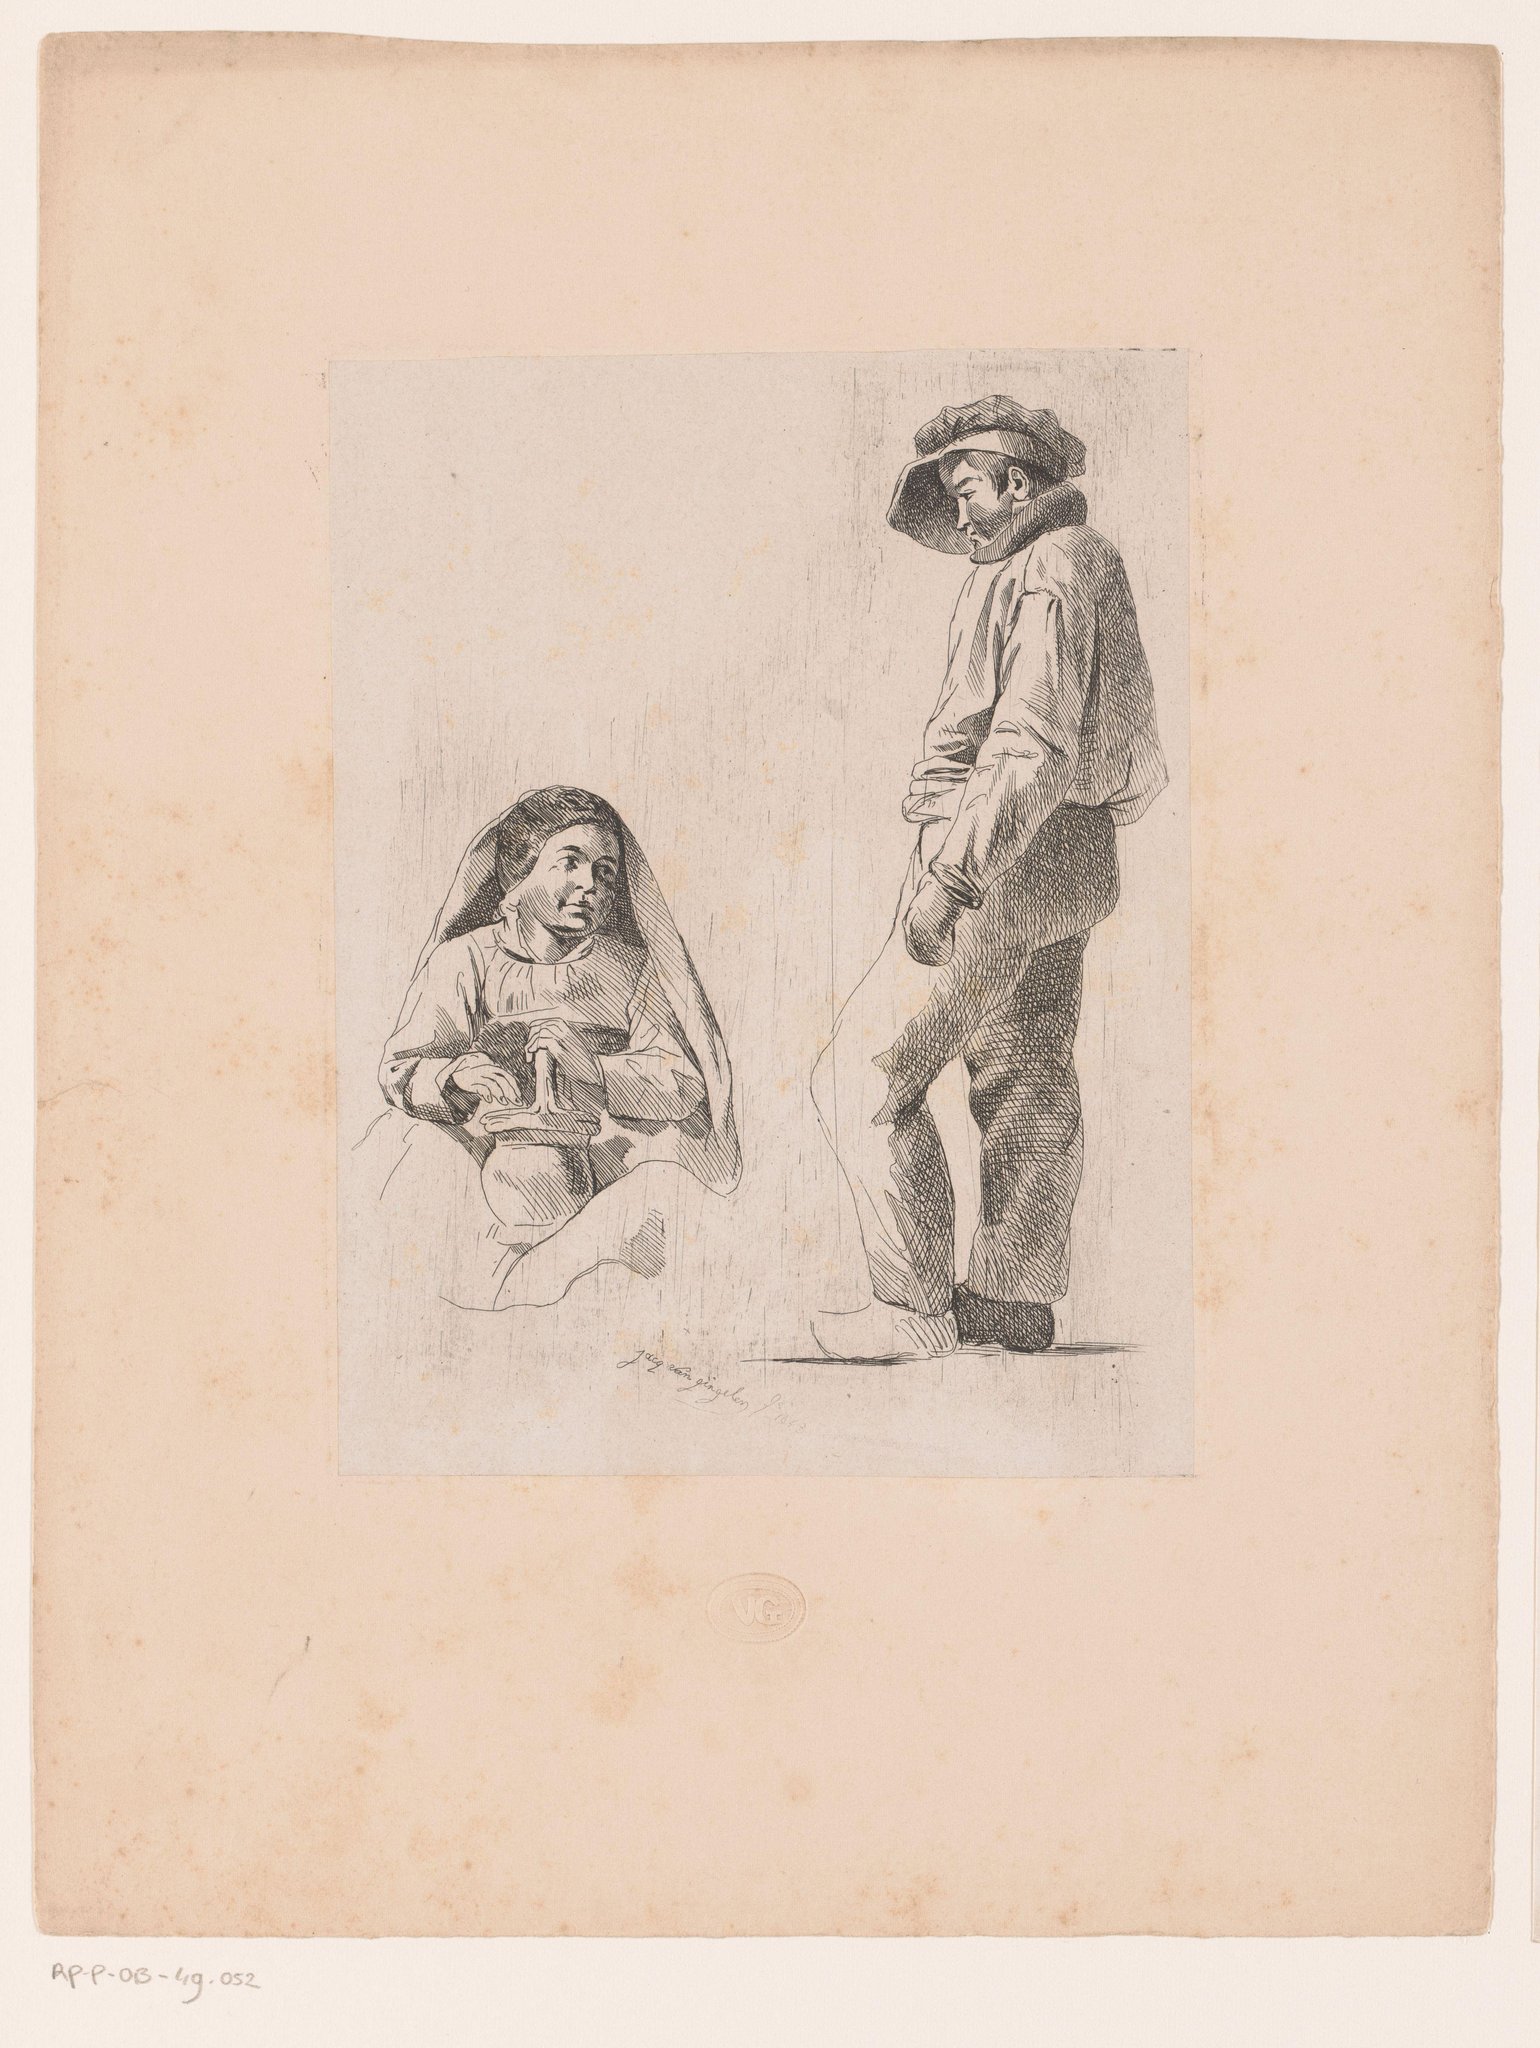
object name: print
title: Staande jongen met pet en een zittend meisje met een mand op schoot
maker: jacques van gingelen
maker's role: print maker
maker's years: 1801-1864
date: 1843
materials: paper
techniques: etching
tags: adolescent, young woman, maiden, youth, adolescent, head-gear: cap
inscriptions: collector's mark: Lugt 2228, mark: ‘JVG’